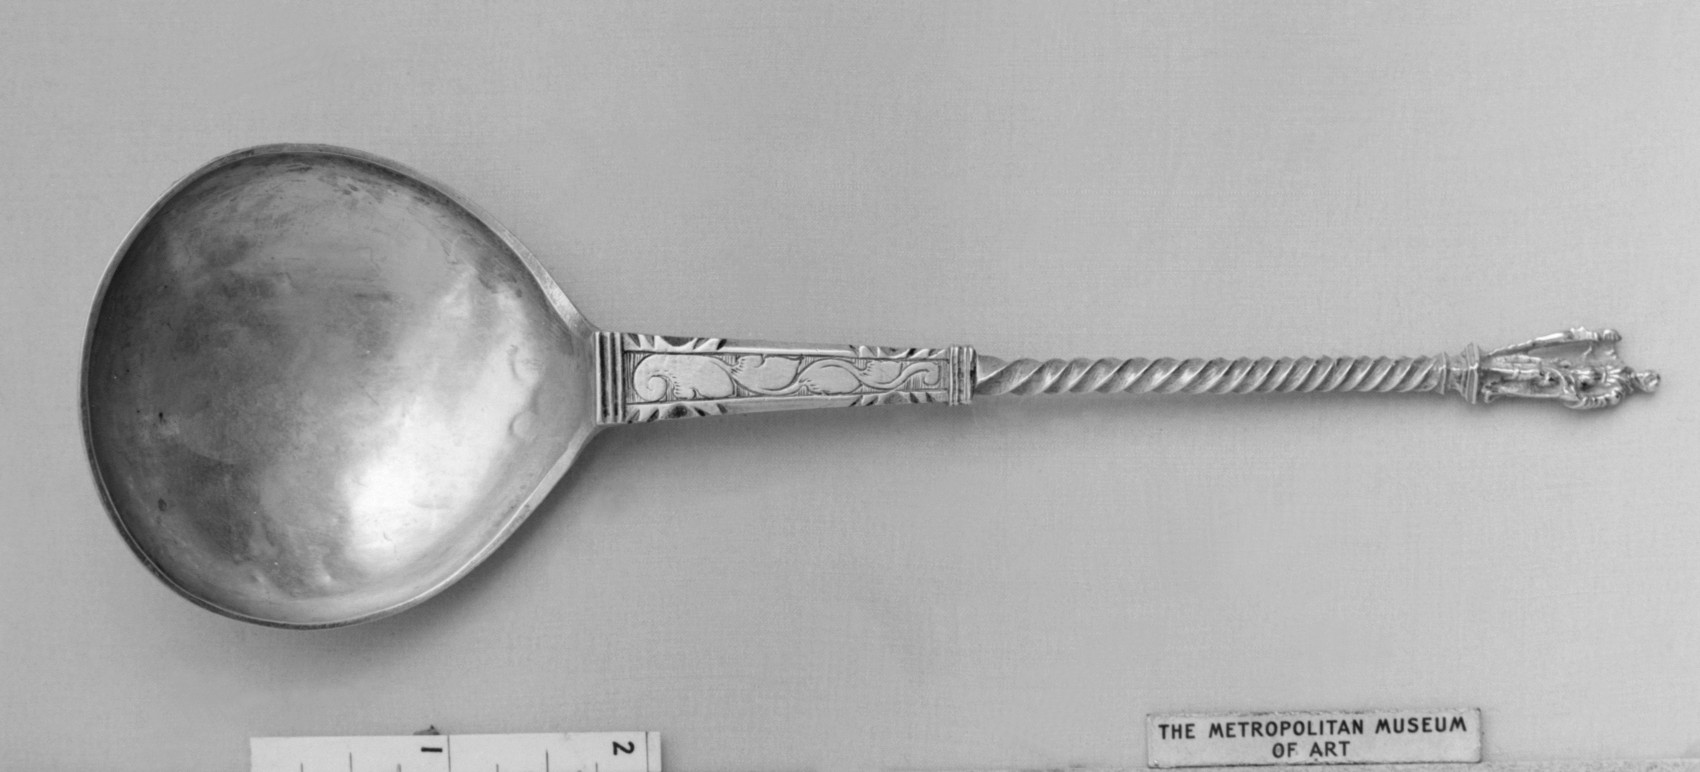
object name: apostle spoon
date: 1632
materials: silver